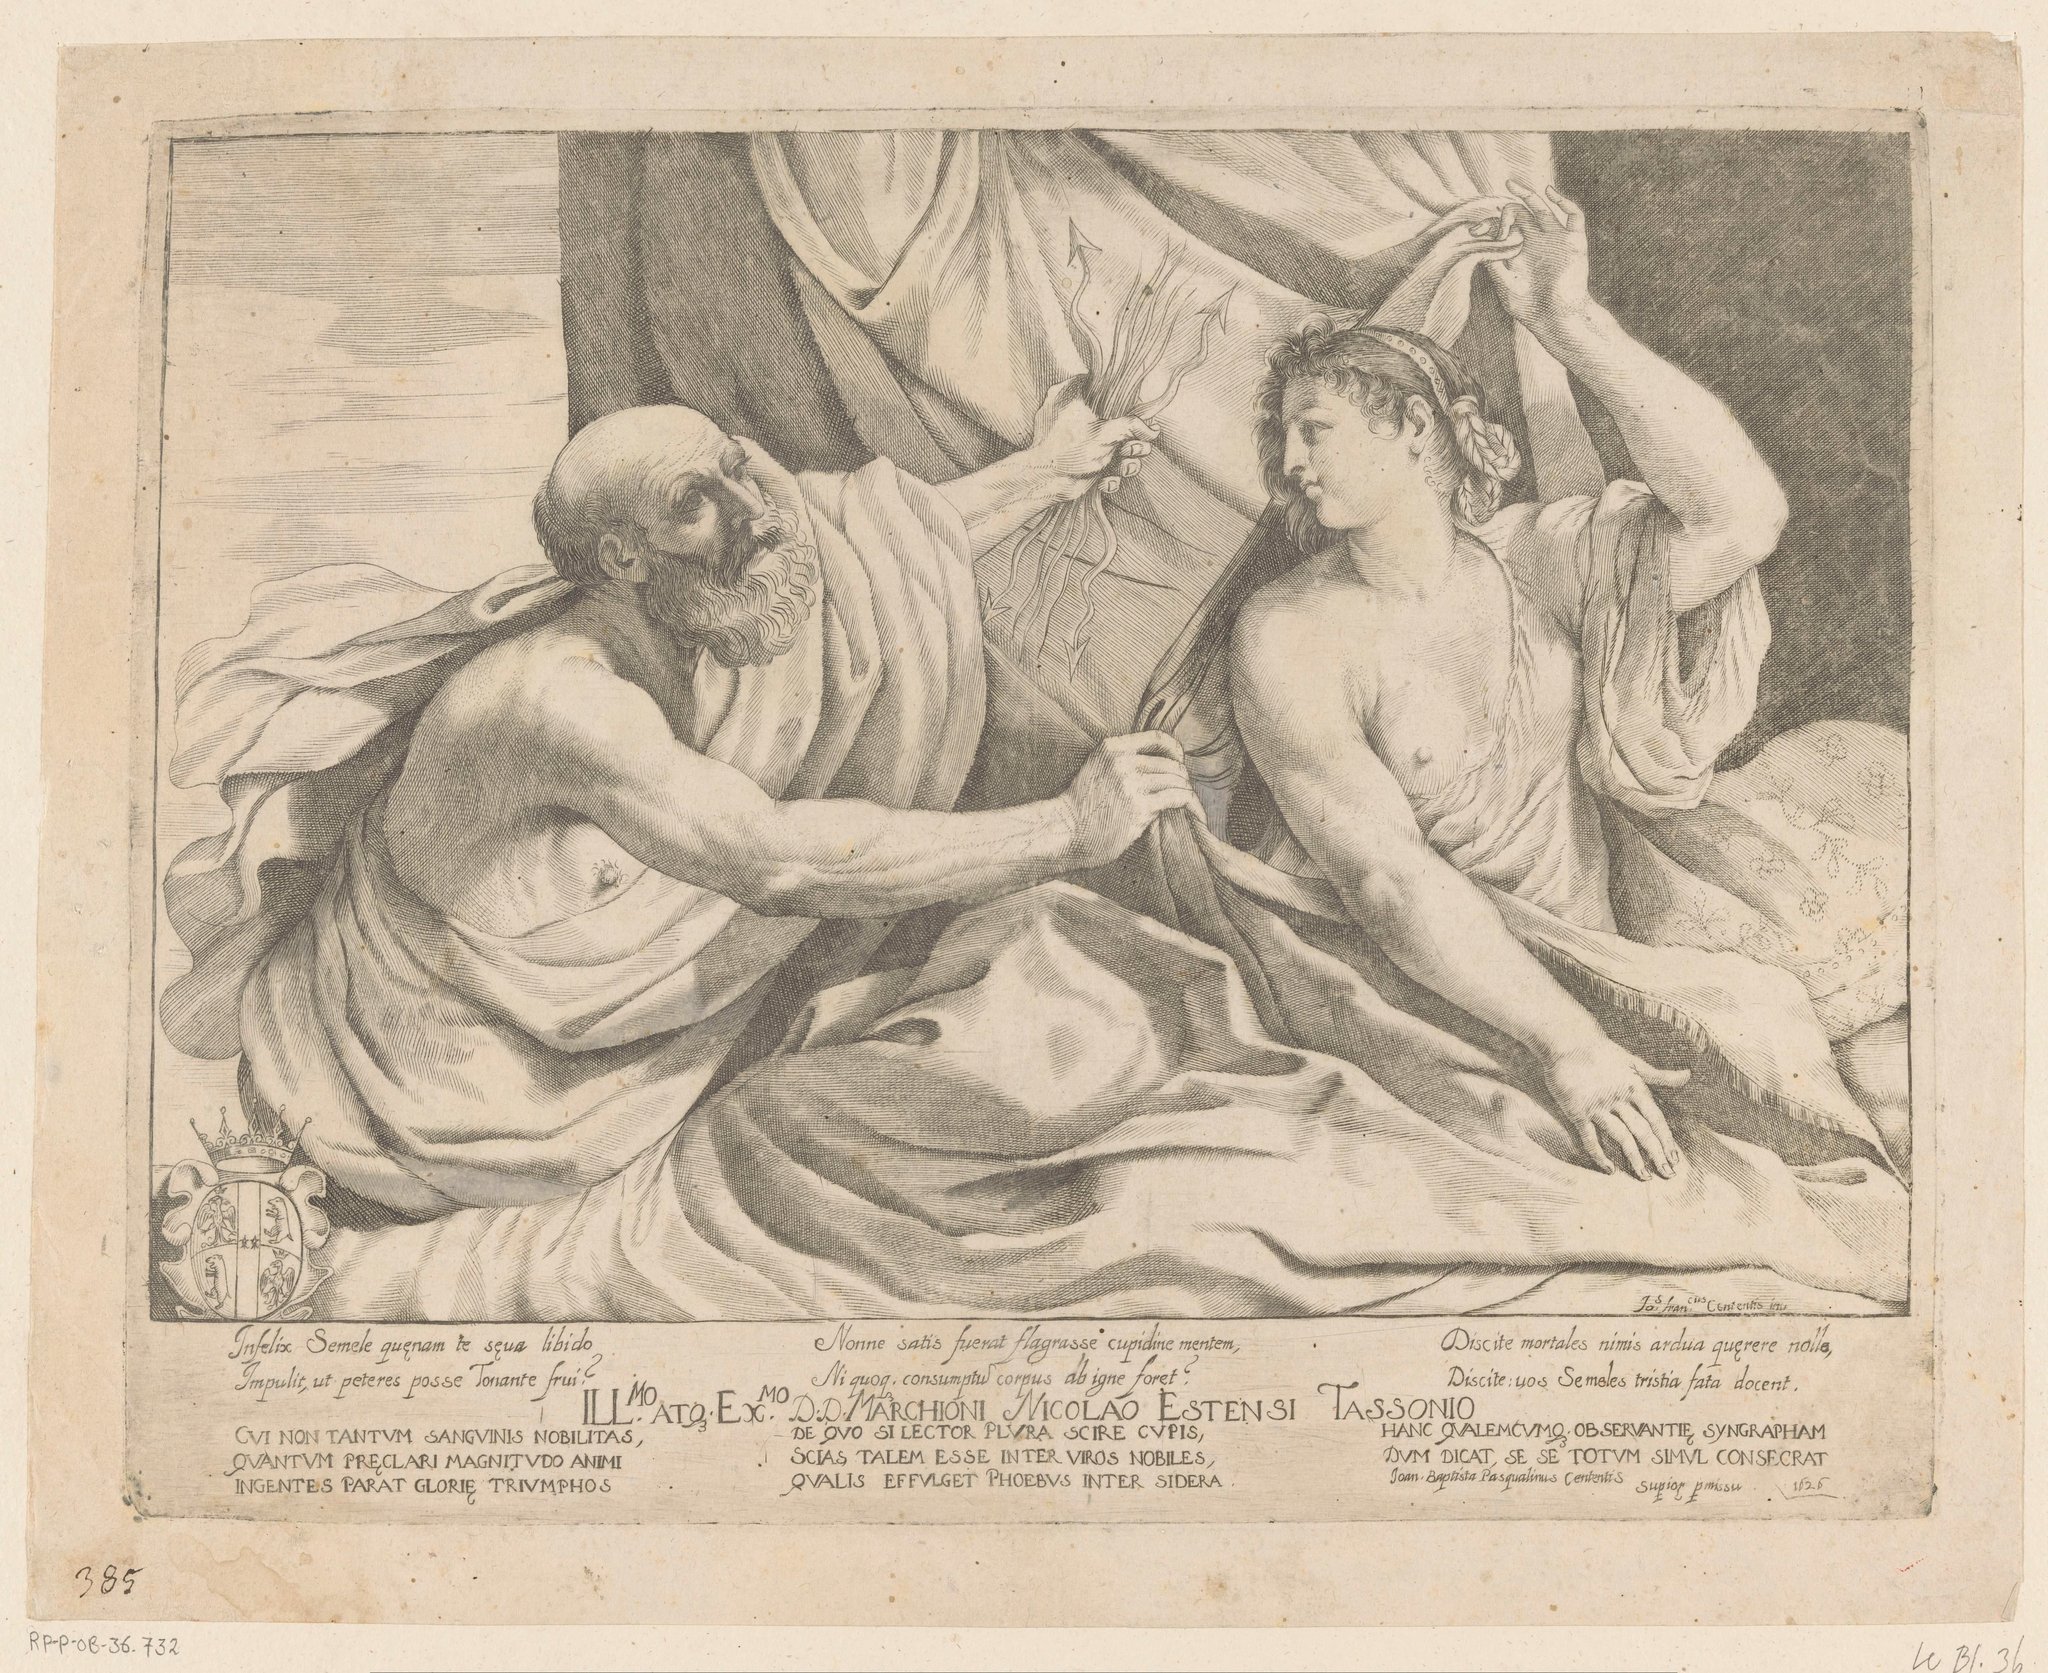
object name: print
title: Jupiter en Semele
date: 1626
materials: paper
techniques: engraving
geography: italy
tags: jupiter kills semele by coming to her with his lightning and thunderbolts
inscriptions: number: ‘385’, collector's mark: Lugt 240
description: Jupiter komt met zijn bliksemschichten aan bij het bed van Semele. Zij laat zich door Jupiter in zijn eigen gedaante beminnen, waarbij ze tot as verteerd wordt door de gloed van zijn bliksem. Linksonder een wapenschild en in de ondermarge drie kolommen met tekst in het Latijn.